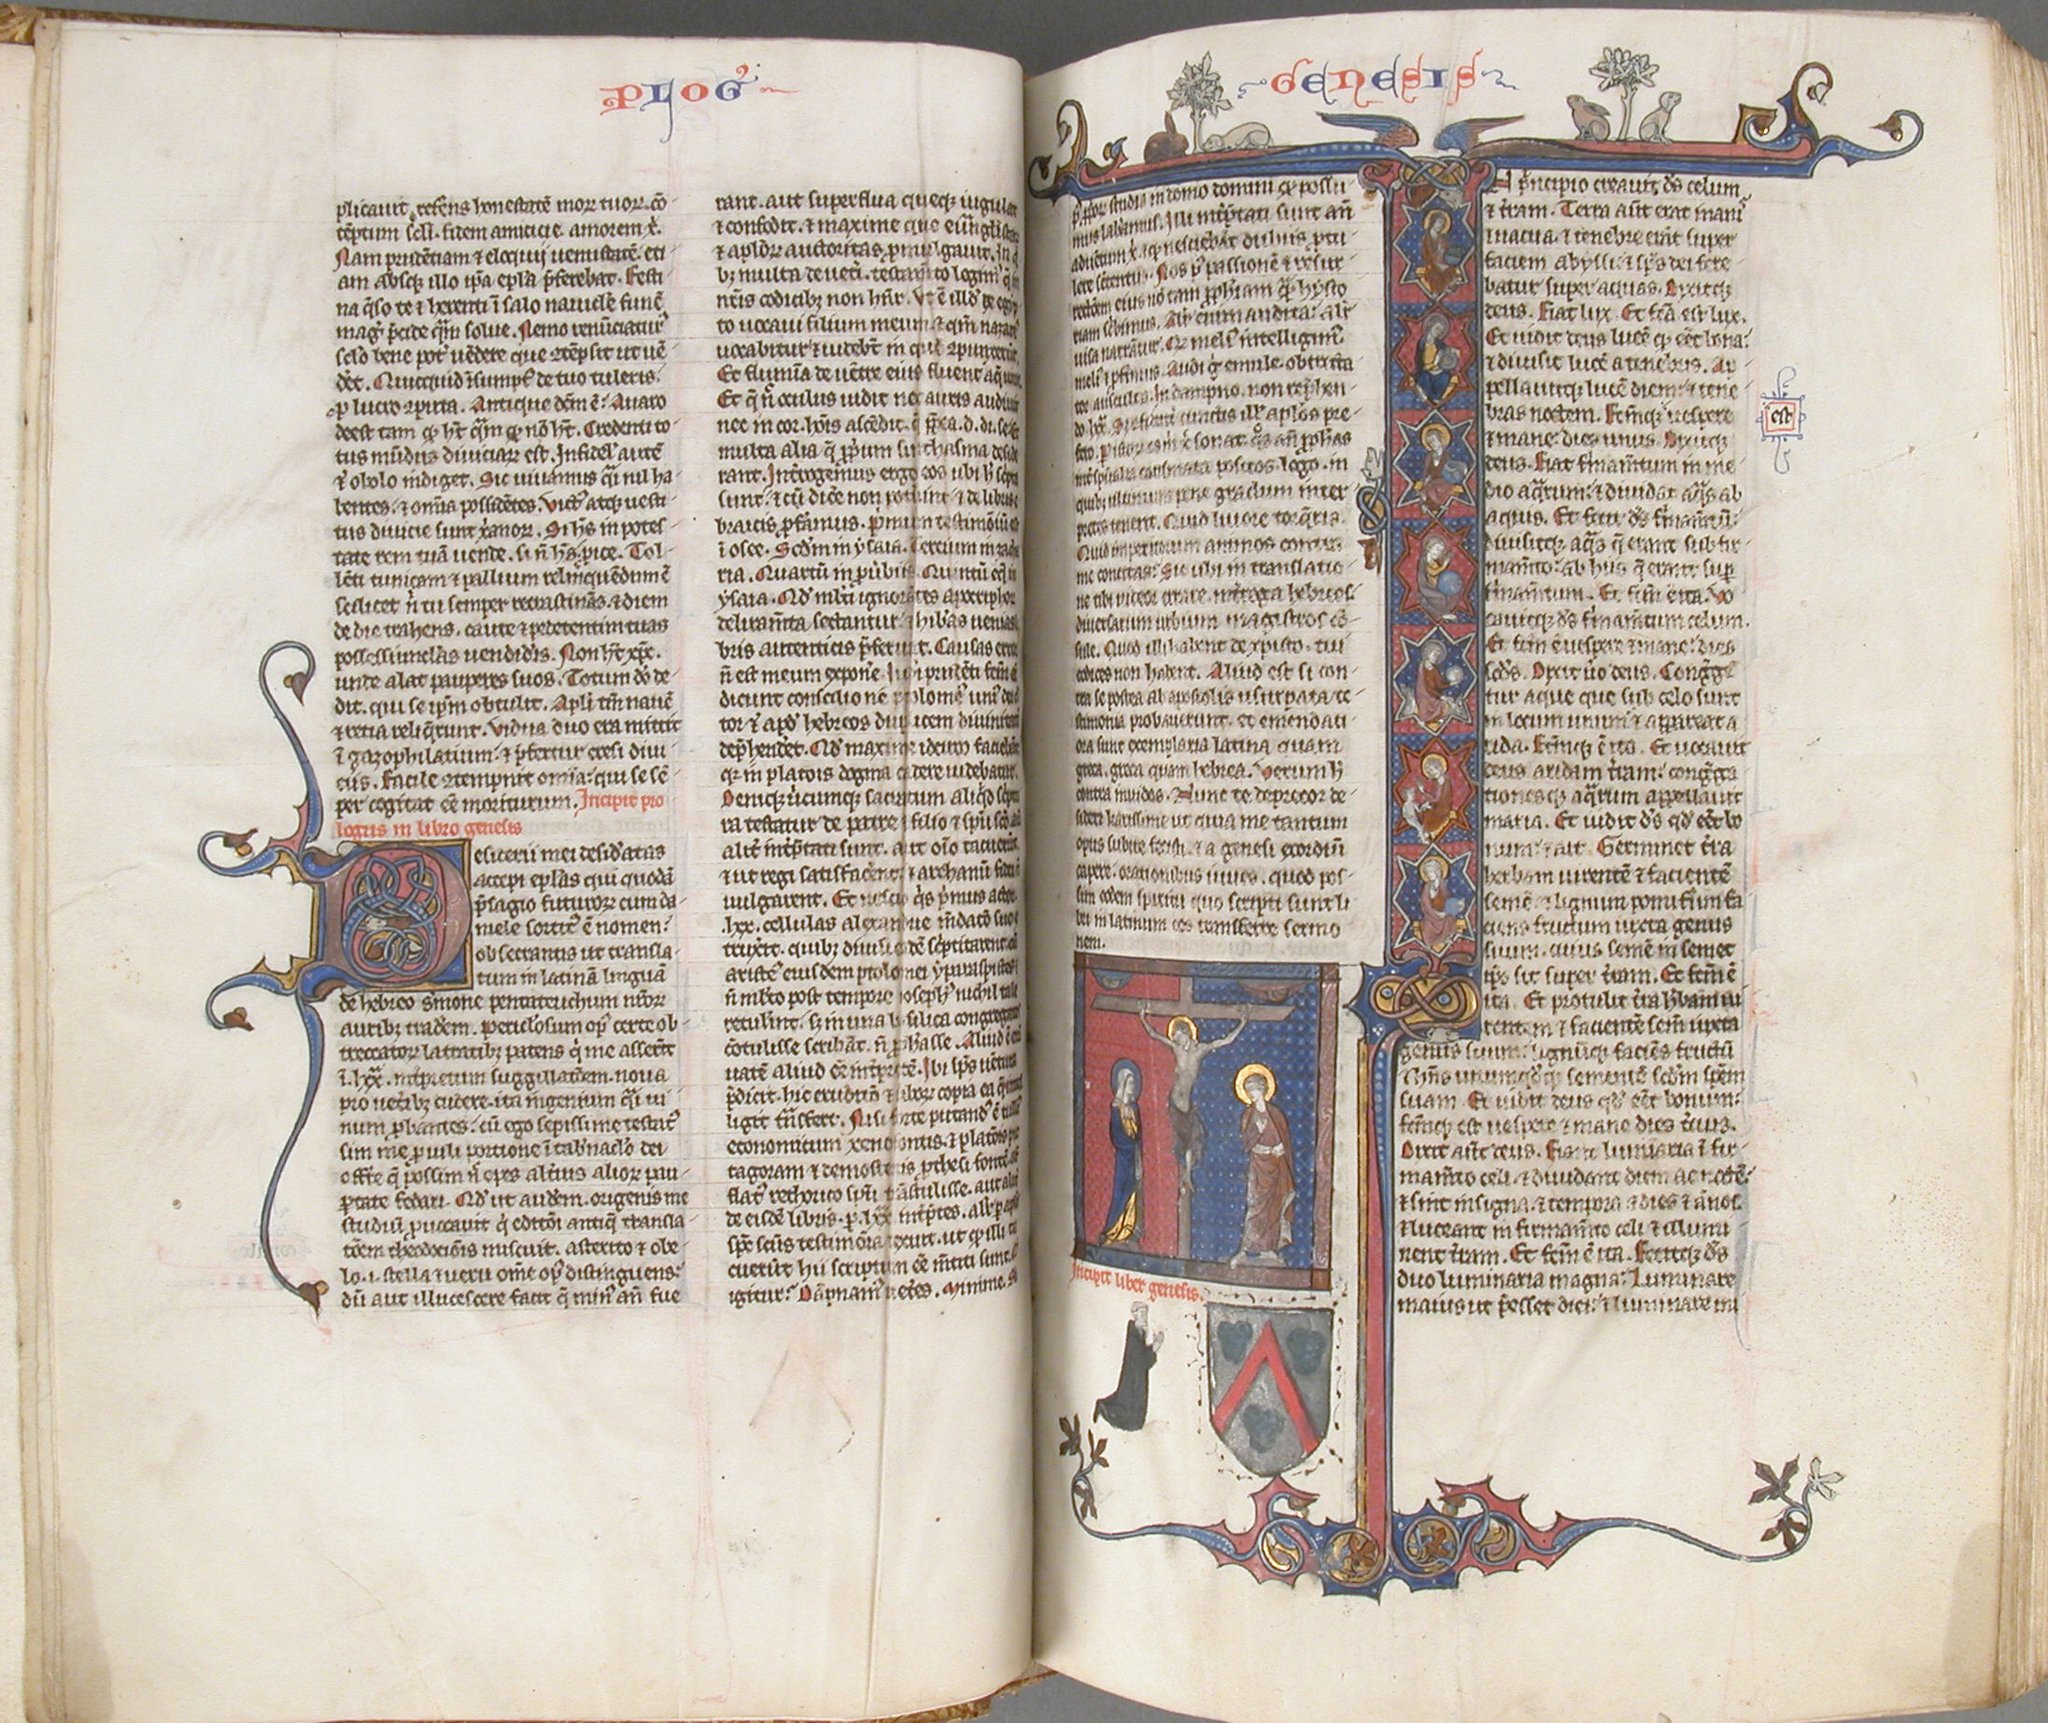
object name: bible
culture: french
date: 1250-1275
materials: gold, leather, parchment, paint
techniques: bookbinding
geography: france